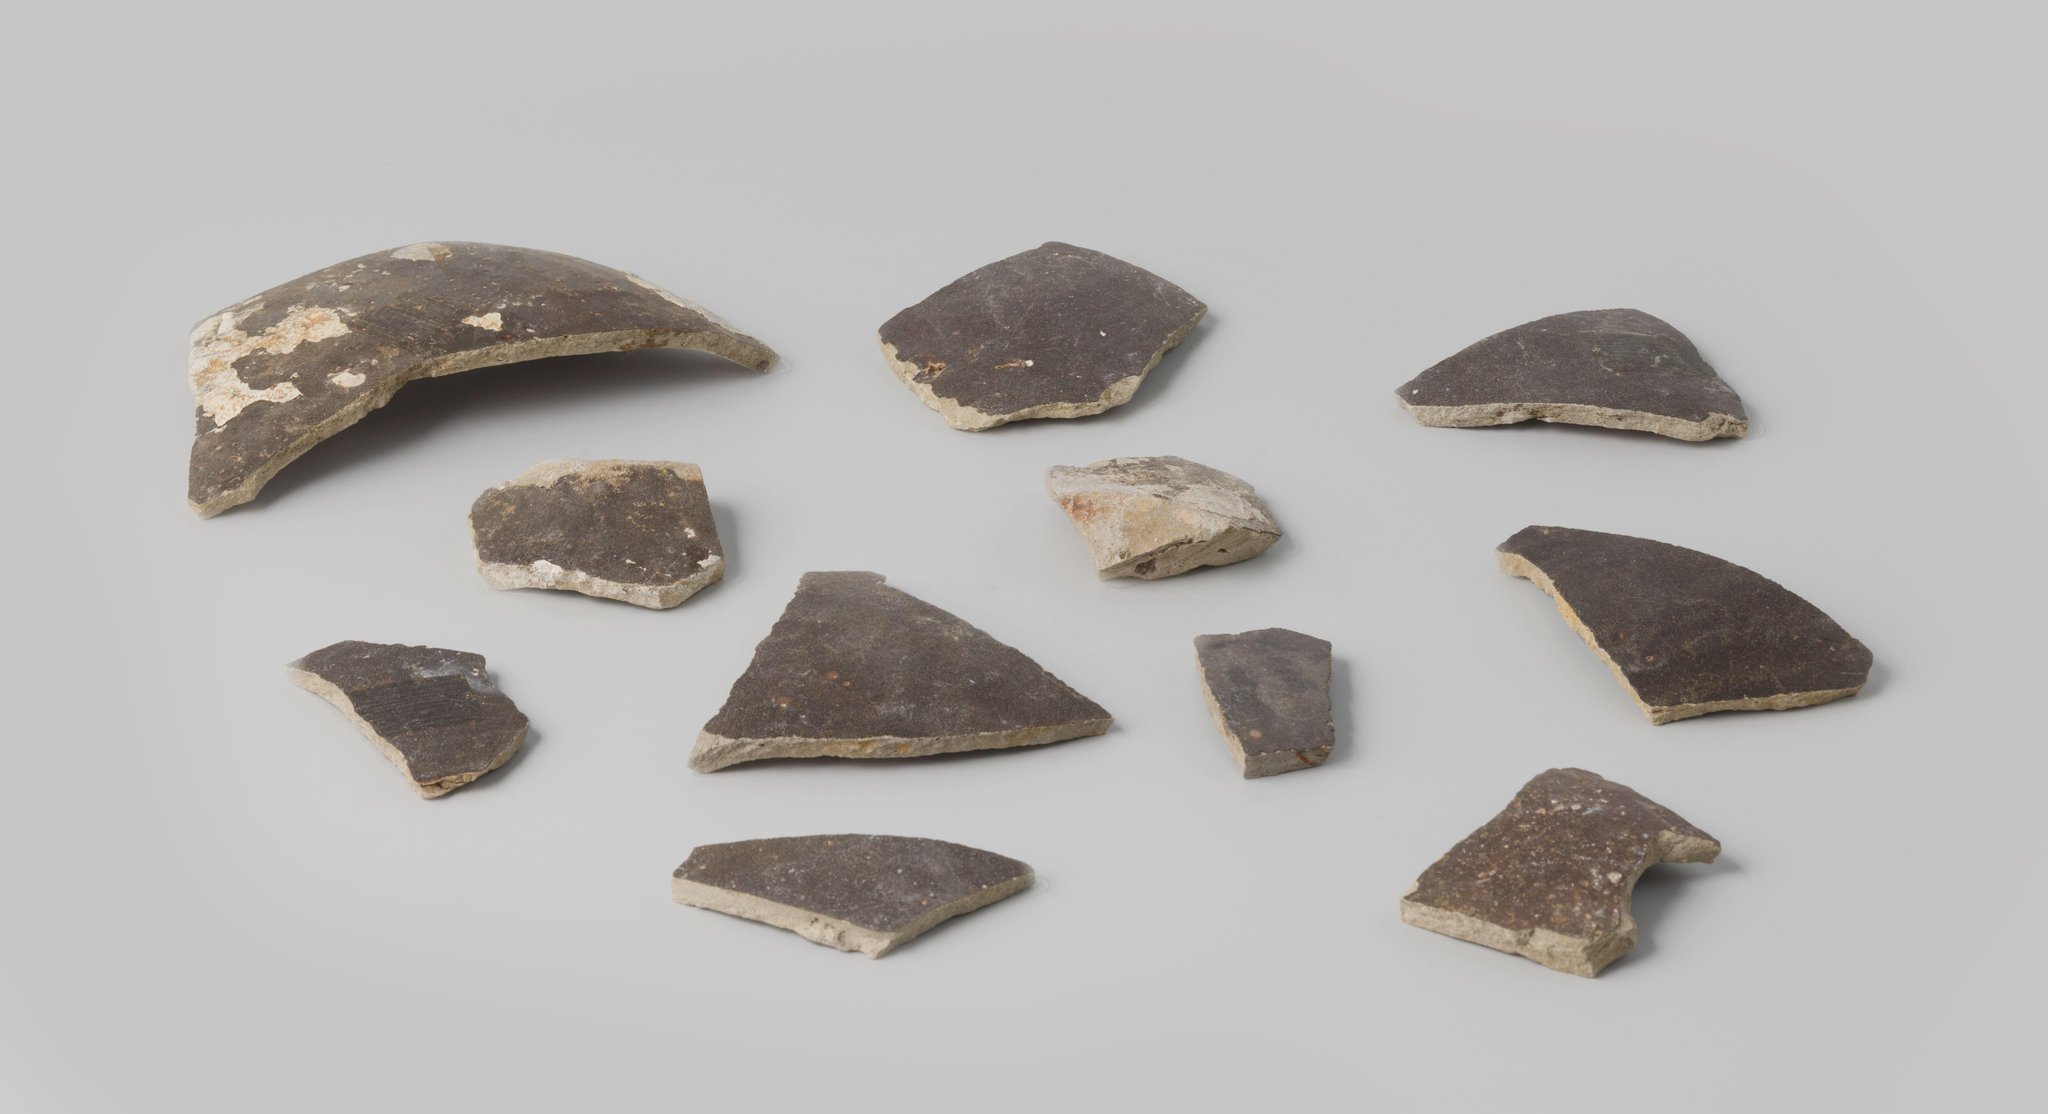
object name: sherd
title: Scherven van martavanen uit V.O.C.-schip de 'Witte Leeuw'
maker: Anonymous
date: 1613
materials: porcelain, stoneware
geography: southeast asia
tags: verenigde oostindische compagnie, sint-helena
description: A jar. This exceptional jar has a wide waist and narrows towards the neck which ends in a narrow flaring mouth. The thin, double walled base has bursted open. The grey coloured clay contains few impurities. There are no traces of glaze on the outside or inside. It ha possibly been covered with a glaze or a slip. The upper half of the exterior has concentric grooves neatly incised from the neck to the waist.